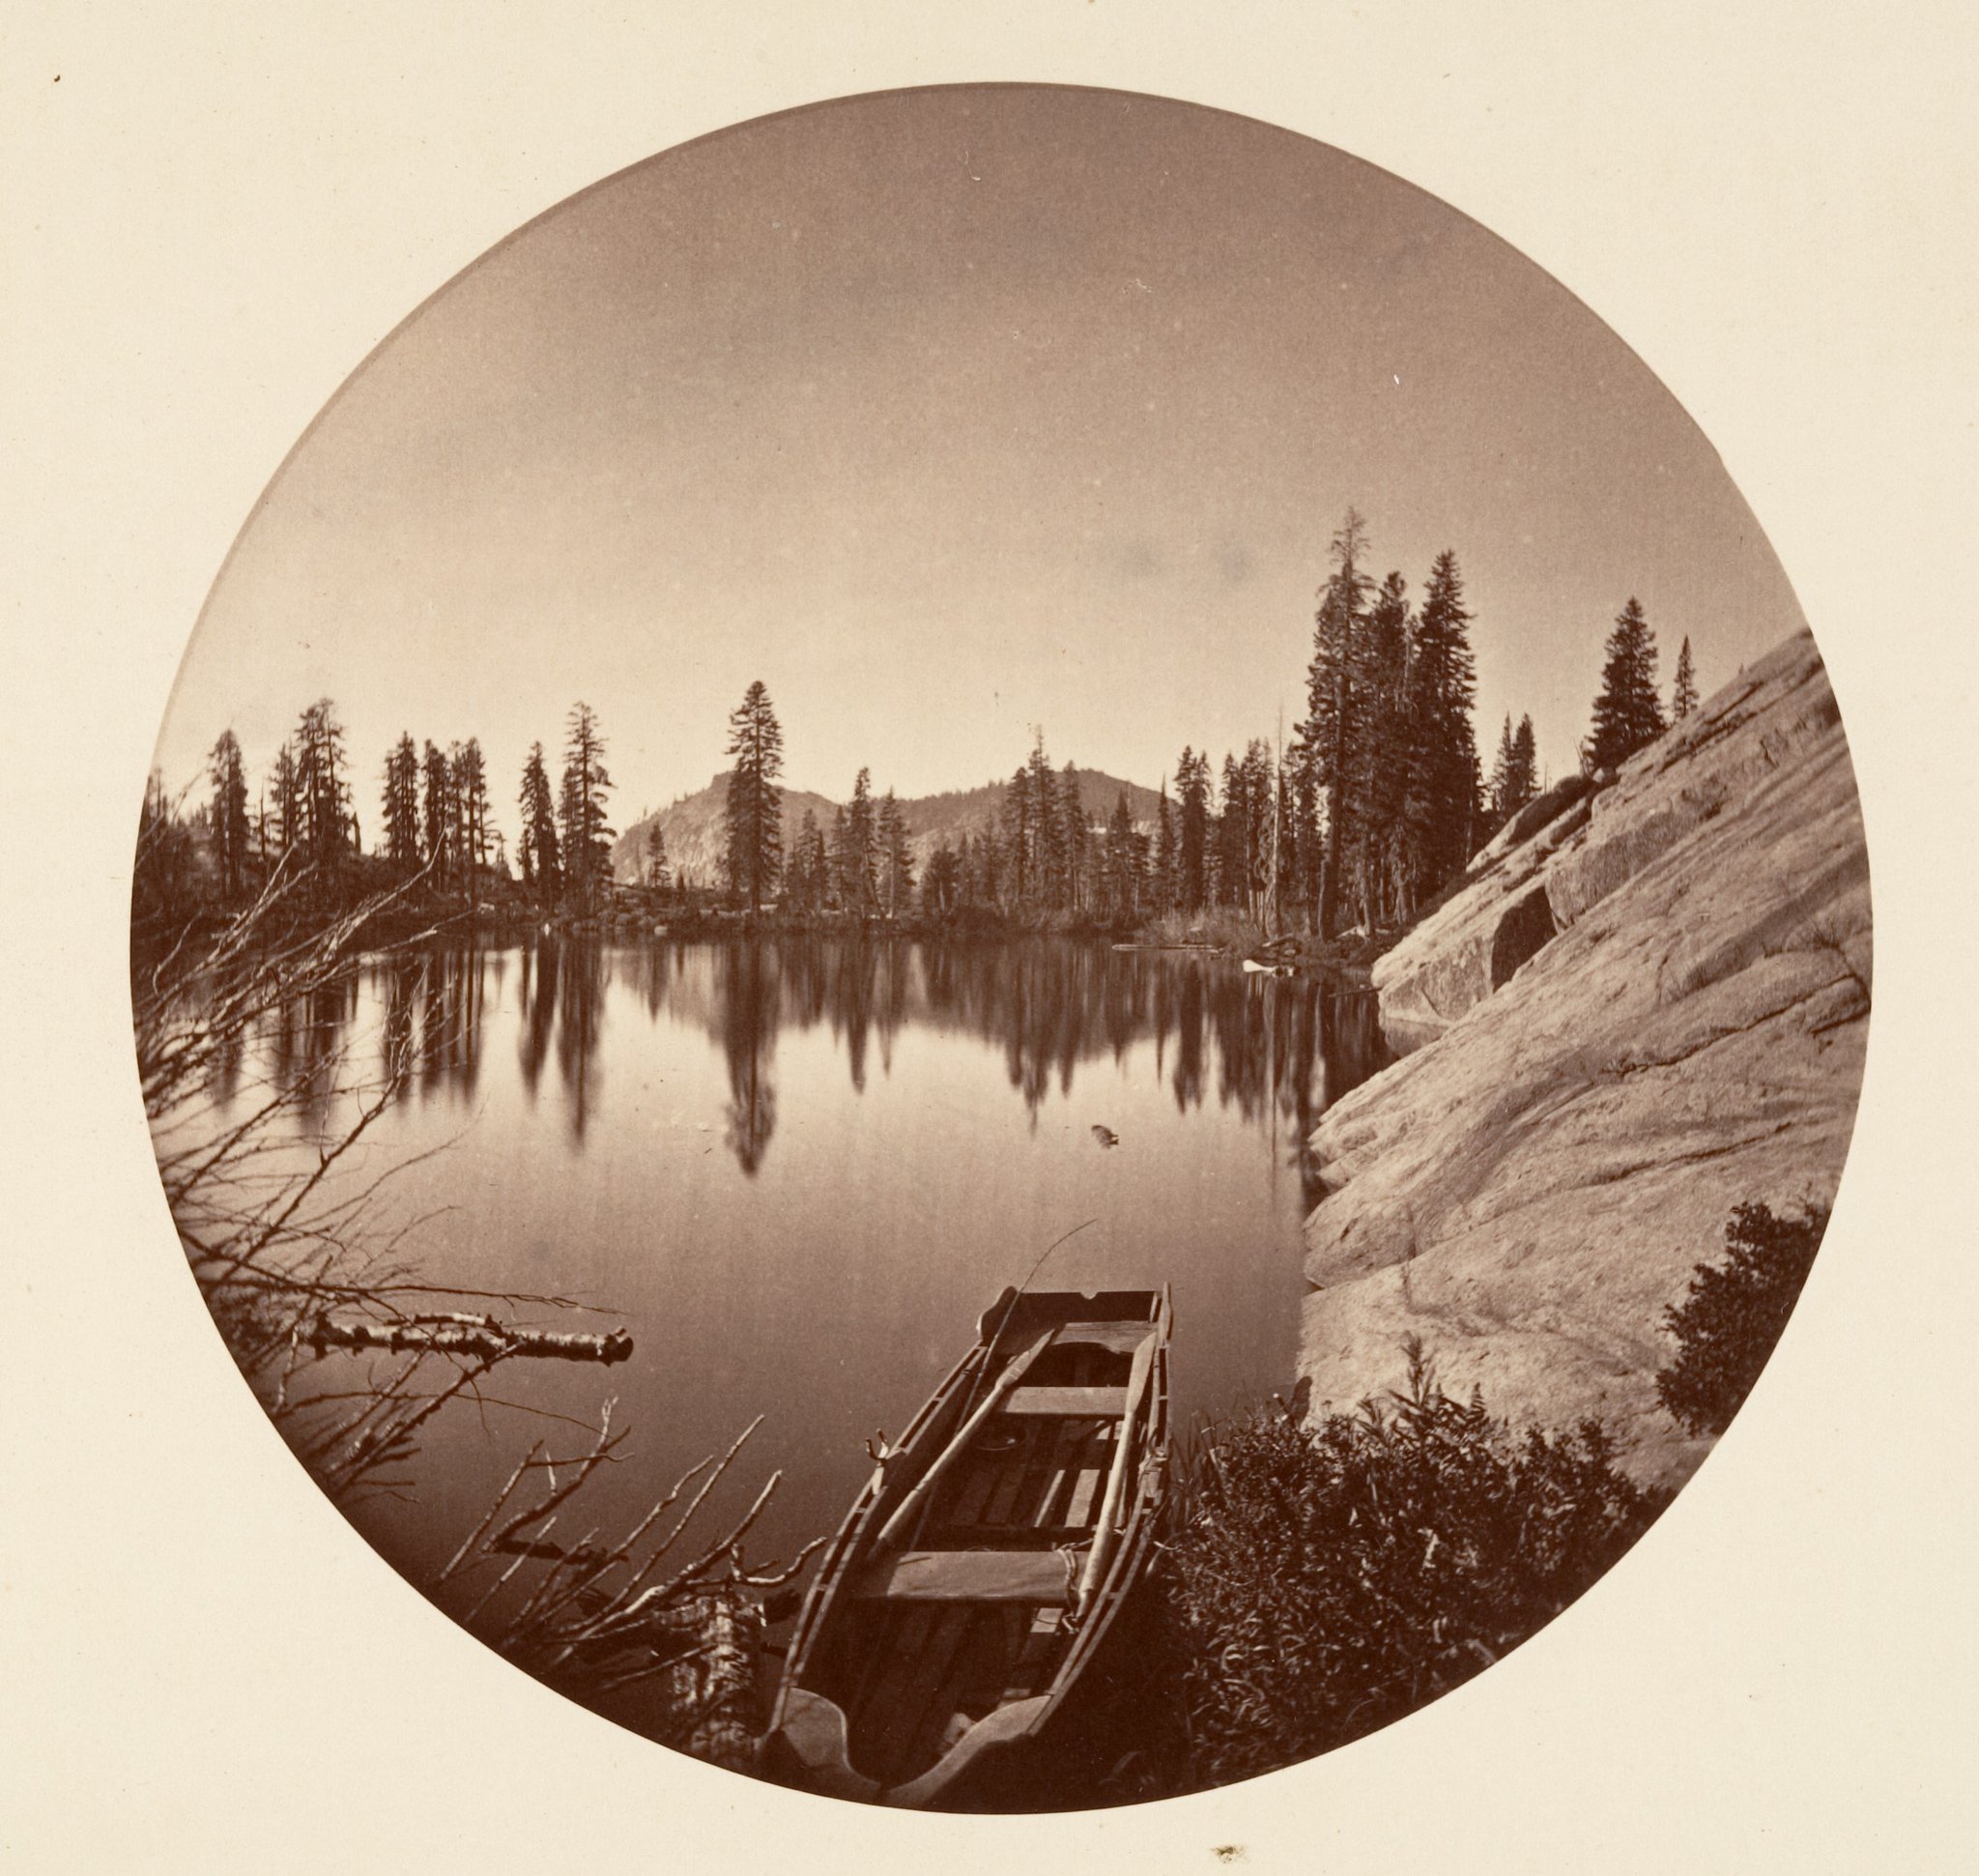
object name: photograph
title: [Yosemite National Park, California]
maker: carleton e. watkins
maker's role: artist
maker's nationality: american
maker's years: 1829-1916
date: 1878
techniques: albumen silver print, glass negative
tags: lakes,mountains,landscapes,boats